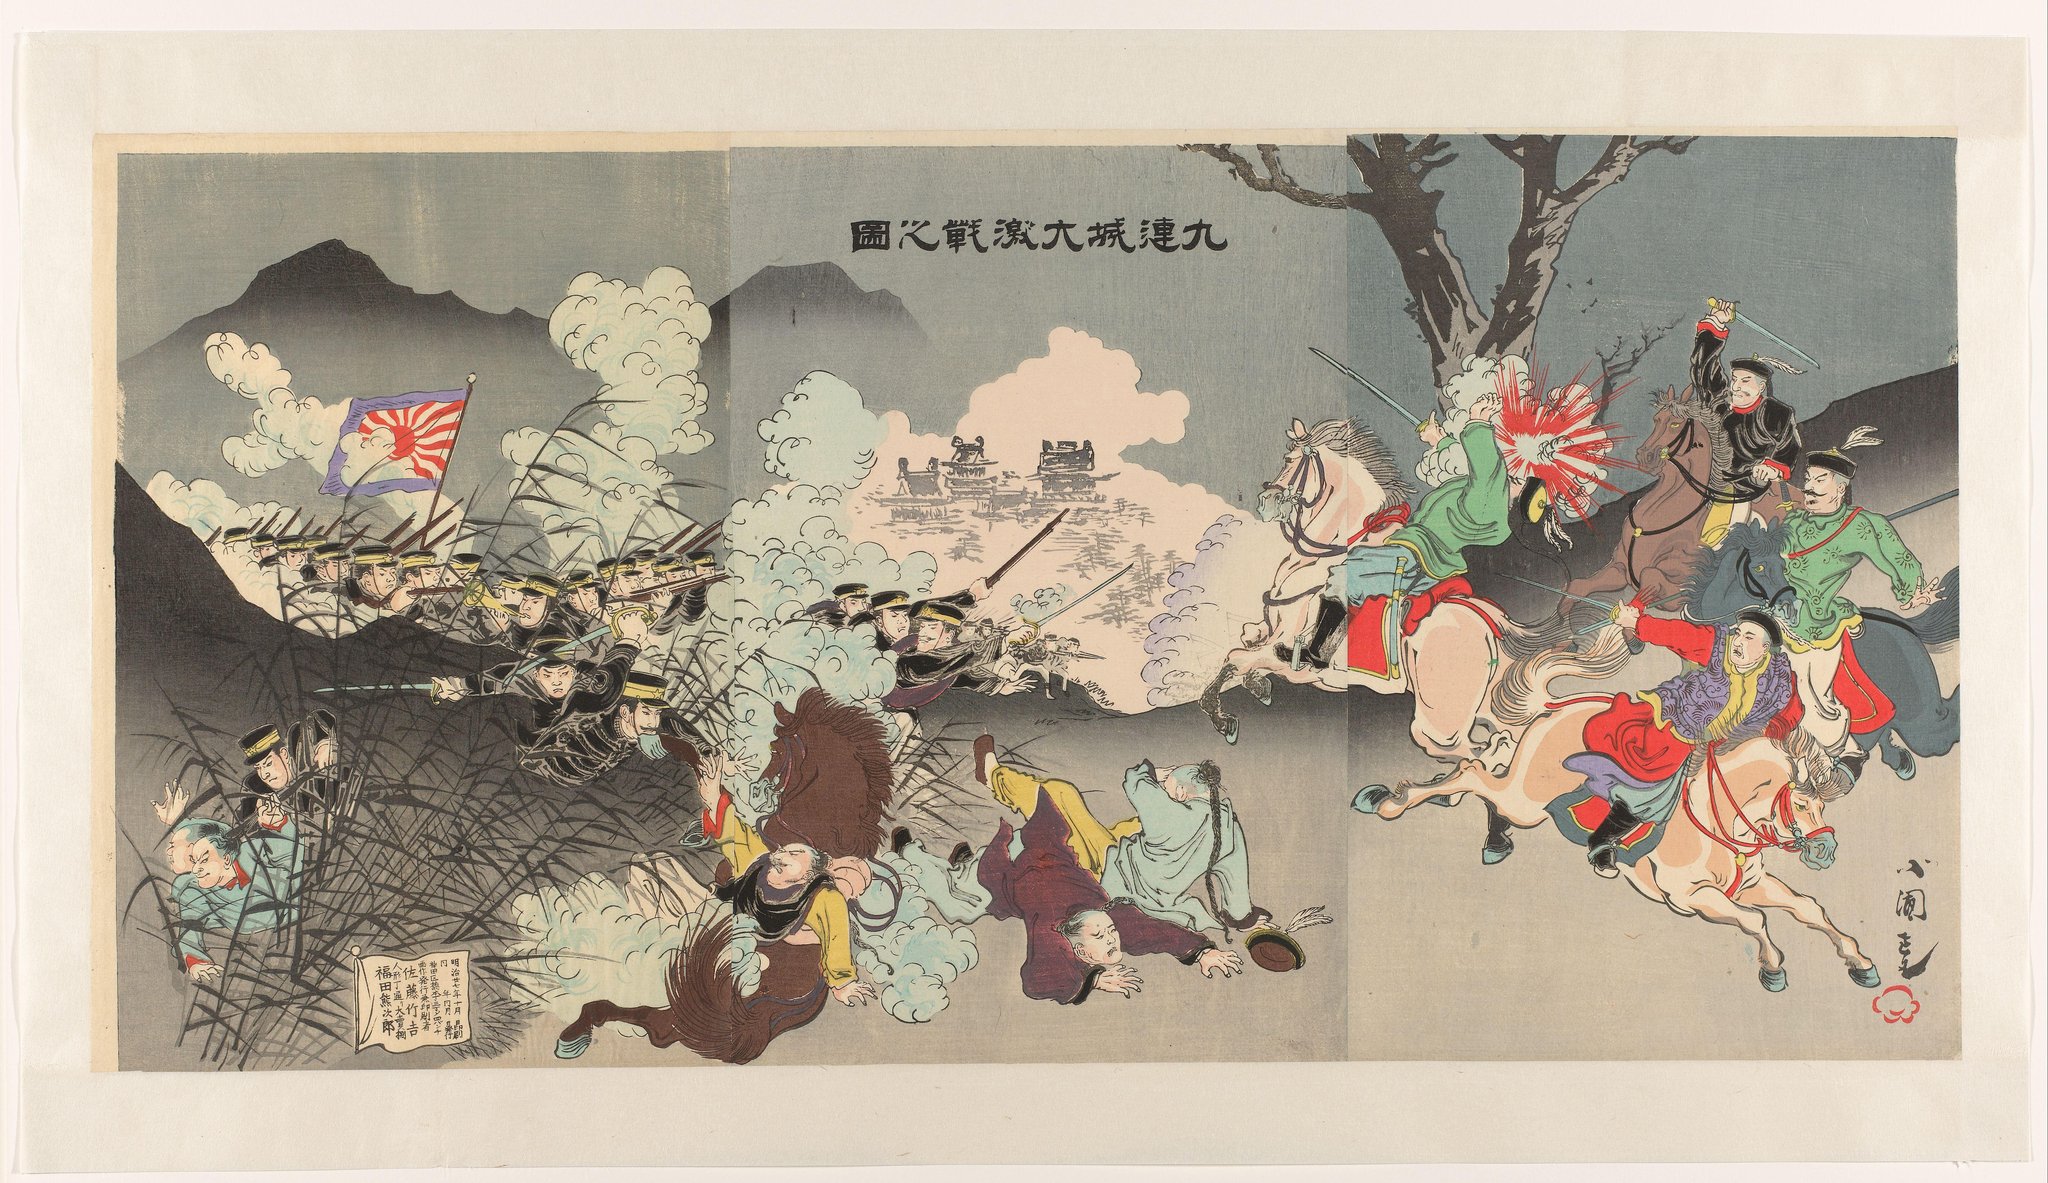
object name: print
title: De grote slag van Jiuliancheng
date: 1894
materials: paper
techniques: woodcut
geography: japan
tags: riding a horse, ass, or mule; rider, horseman, battle, hacking and thrusting weapons: sword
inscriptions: collector's mark: Lugt 2228, label:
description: Japanse soldaten vuren hun geweren op Chinese soldaten te paard die gewapend zijn met slechts hun zwaarden. De slag om Jiuliancheng in Mantsjoerije vond plaats op 26 oktober 1894, tijdens de Eerste Chinees-Japanse Oorlog (1894-1895).